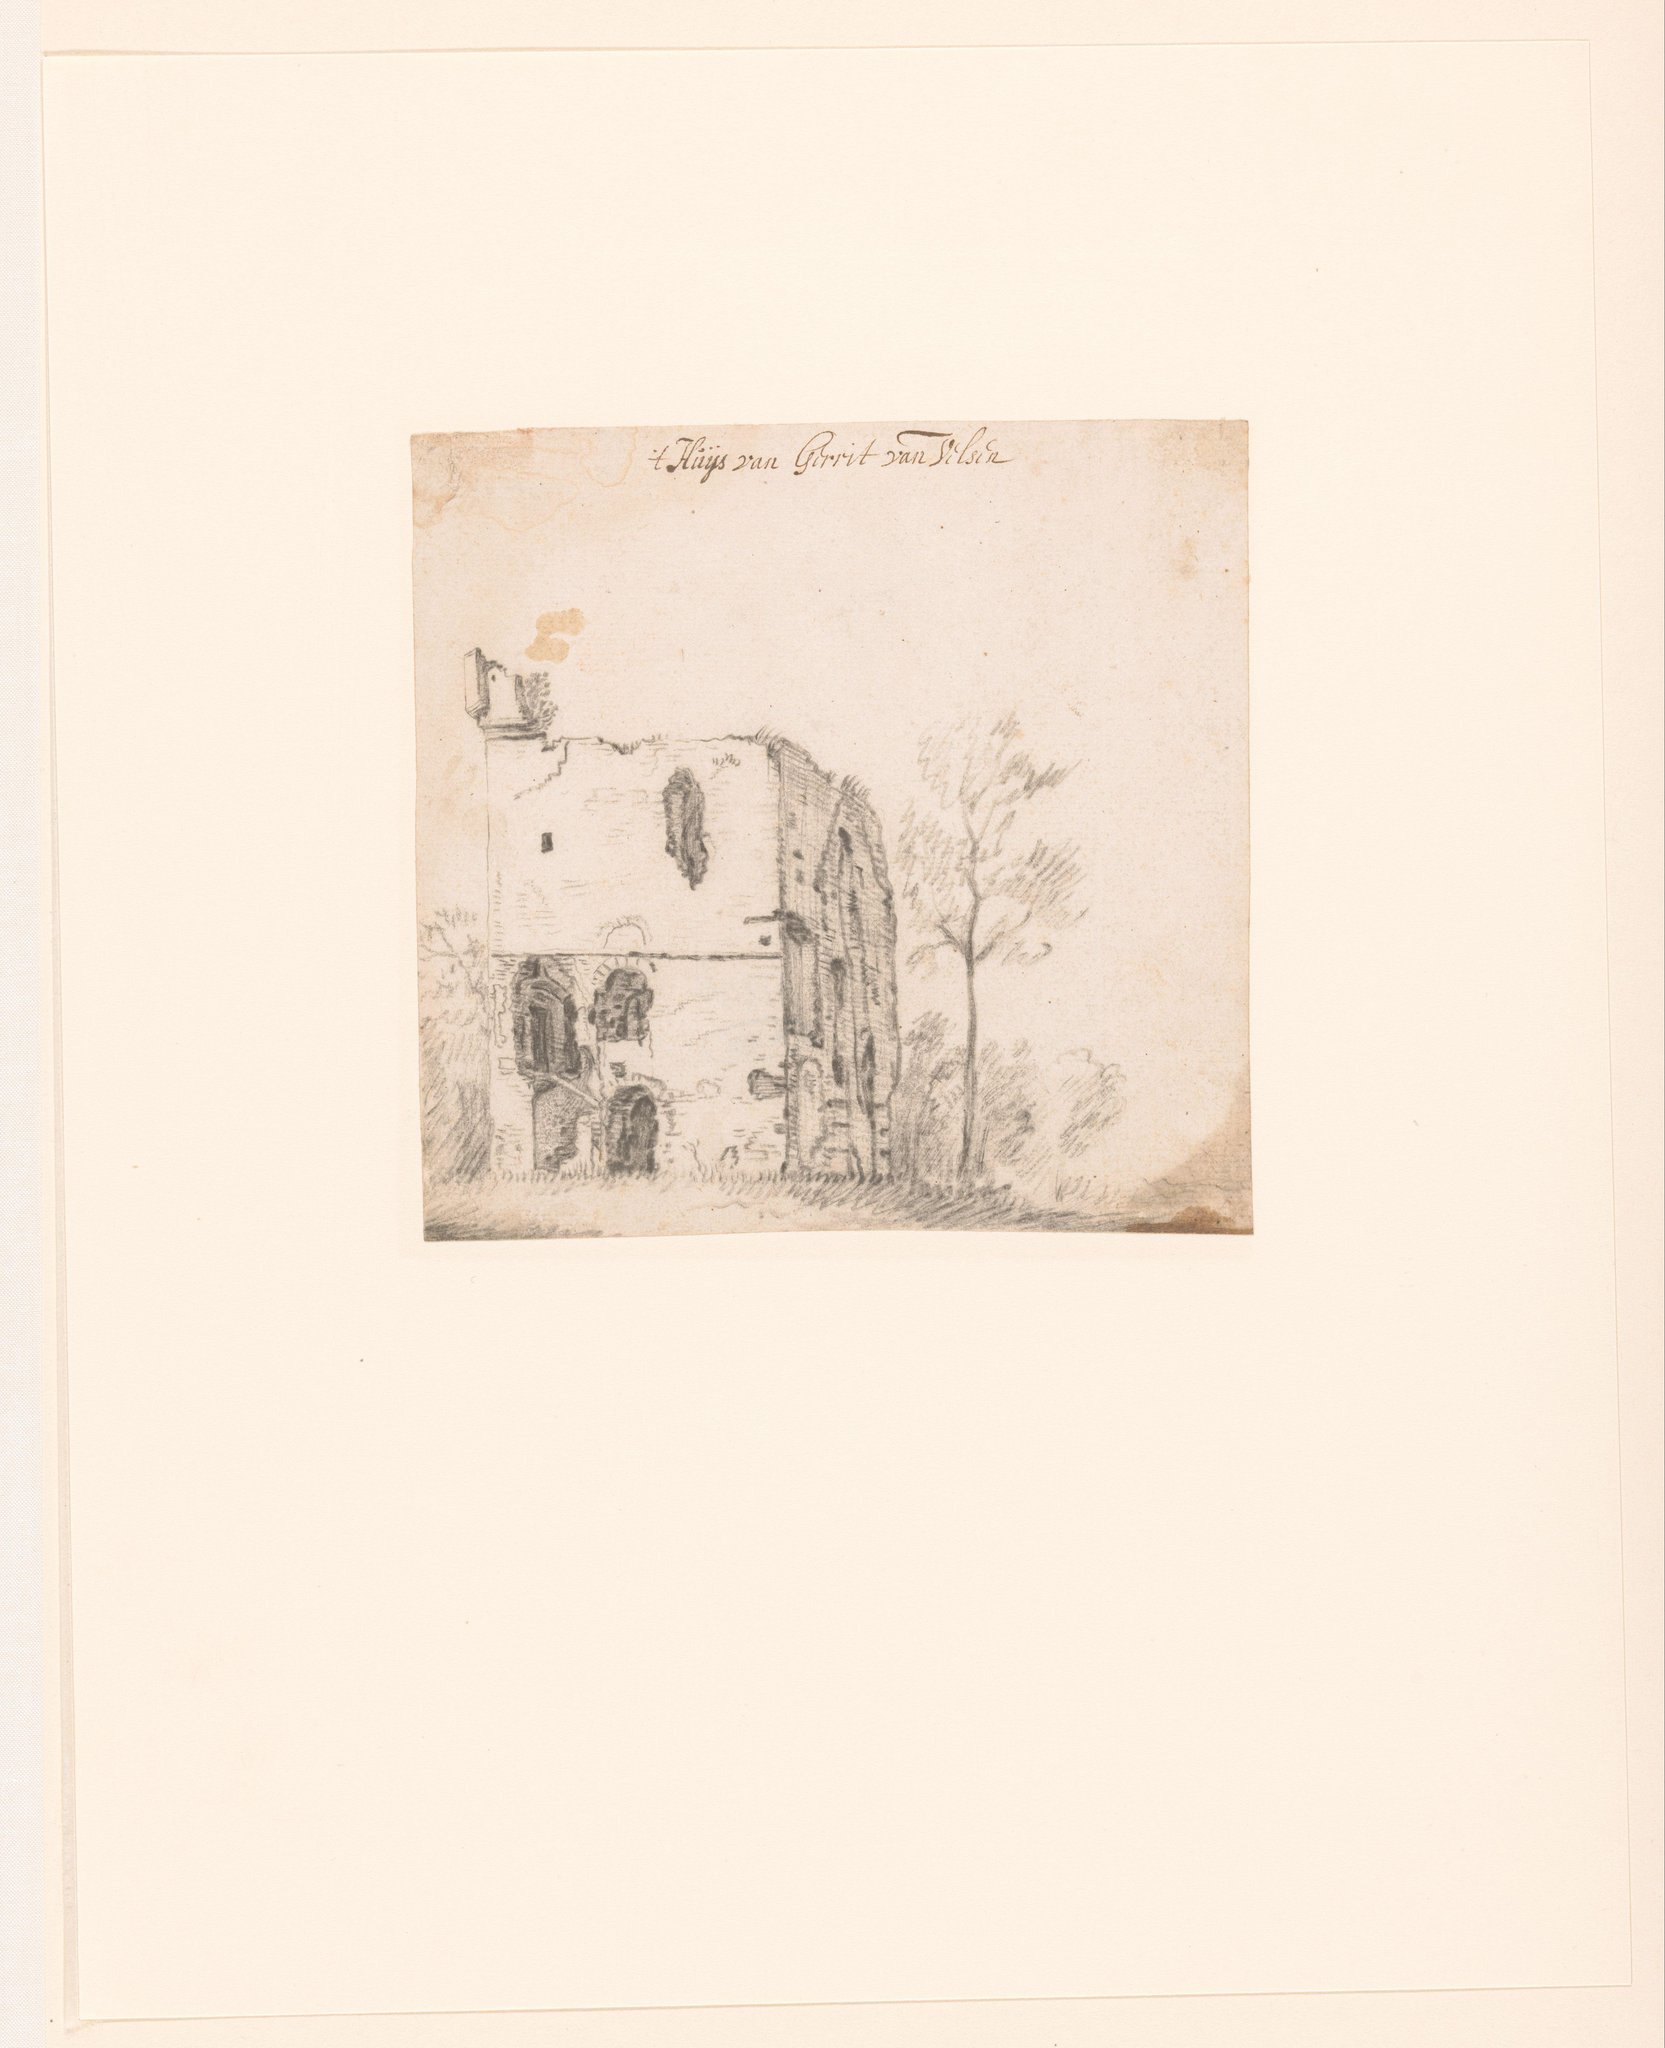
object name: drawing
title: Gezicht op de ruïne van het huis te Velsen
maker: Anonymous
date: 1675-1750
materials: chalk, paper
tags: landscape with ruins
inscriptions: collector's mark: Lugt 2228